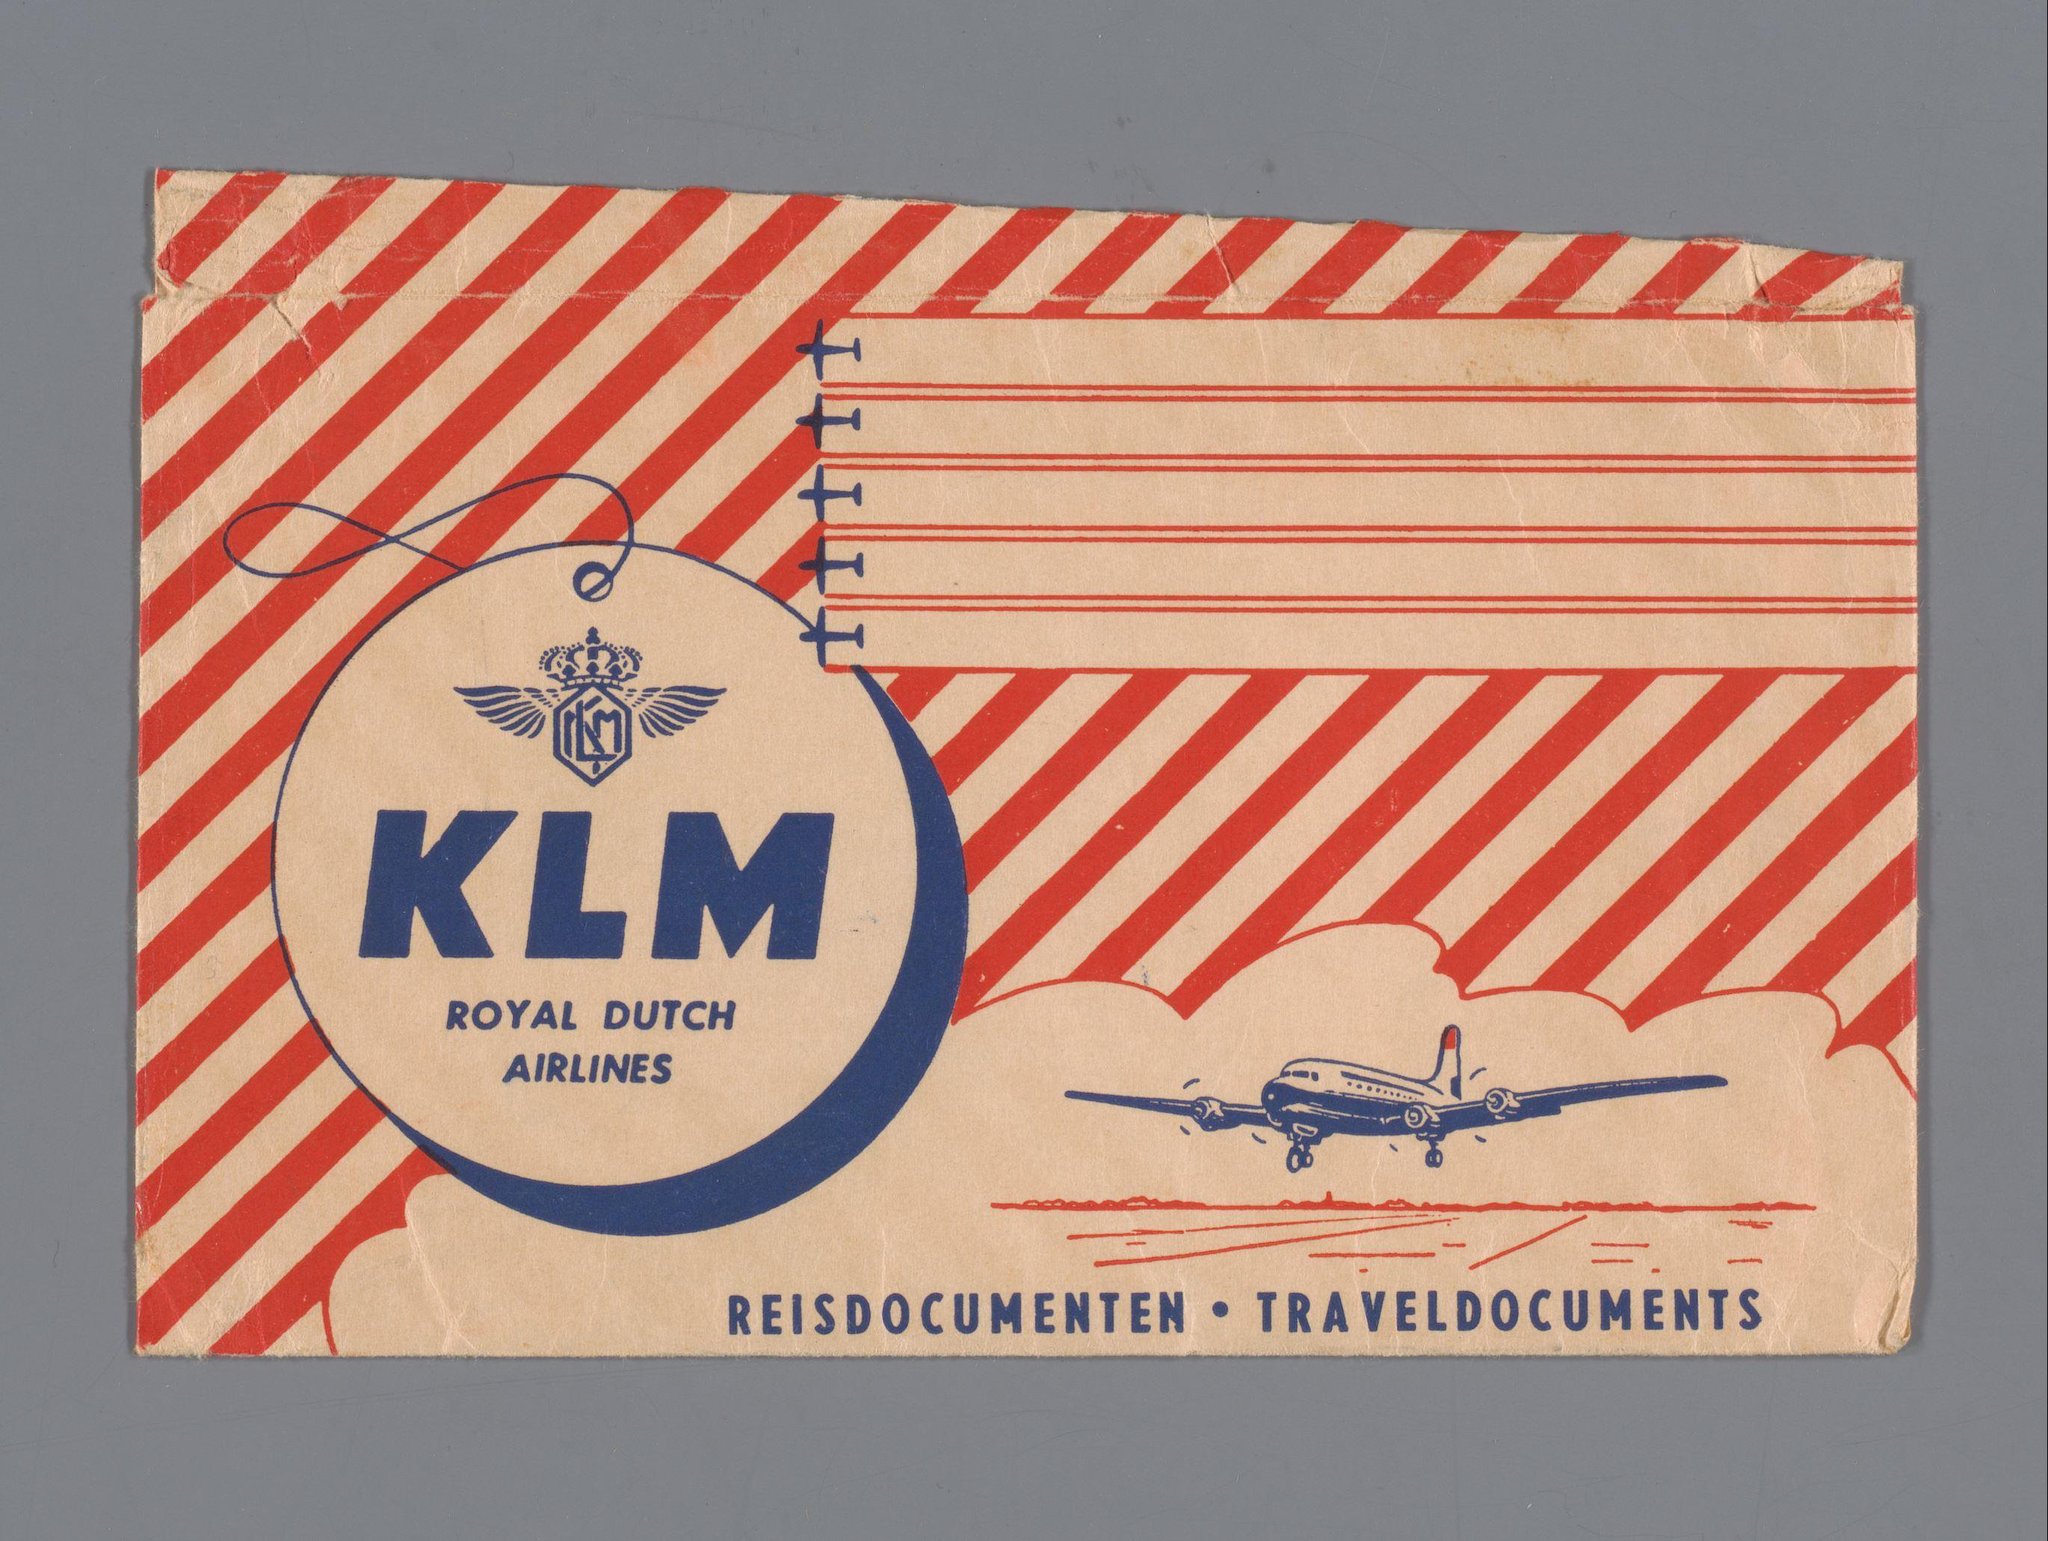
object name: letter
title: Gedichten en liefdesbrieven van Karl-Heinz Arndtheim aan Isabel Wachenheimer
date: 1948-1949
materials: paper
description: Dit object is onderdeel van de nalatenschap van Isabel Elon-Wachenheimer (1928-2010). Tot haar overlijden behoorde het samen met de andere objecten uit de nalatenschap tot haar privédomein van Isabel Wachenheimer. In die particuliere context zijn deze objecten tezamen en individueel aandenkens - aan de jeugd, ouders en familie van Isabel Wachenheimer vóór en tijdens de Shoah en aan haar leven na de Tweede Wereldoorlog. Isabel Wachenheimer, die van juni 1943 tot mei 1945 gevangen zat in Kamp Westerbork, Theresienstadt, Auschwitz, Lenzing a/d Oberdonau (een buitenkamp van Mauthausen), overleefde de Shoah. Haar ouders – Eugène Wachenheimer en Else Wachenheimer-Moos - werden op 14 oktober 1944 in Auschwitz-Birkenau vermoord.